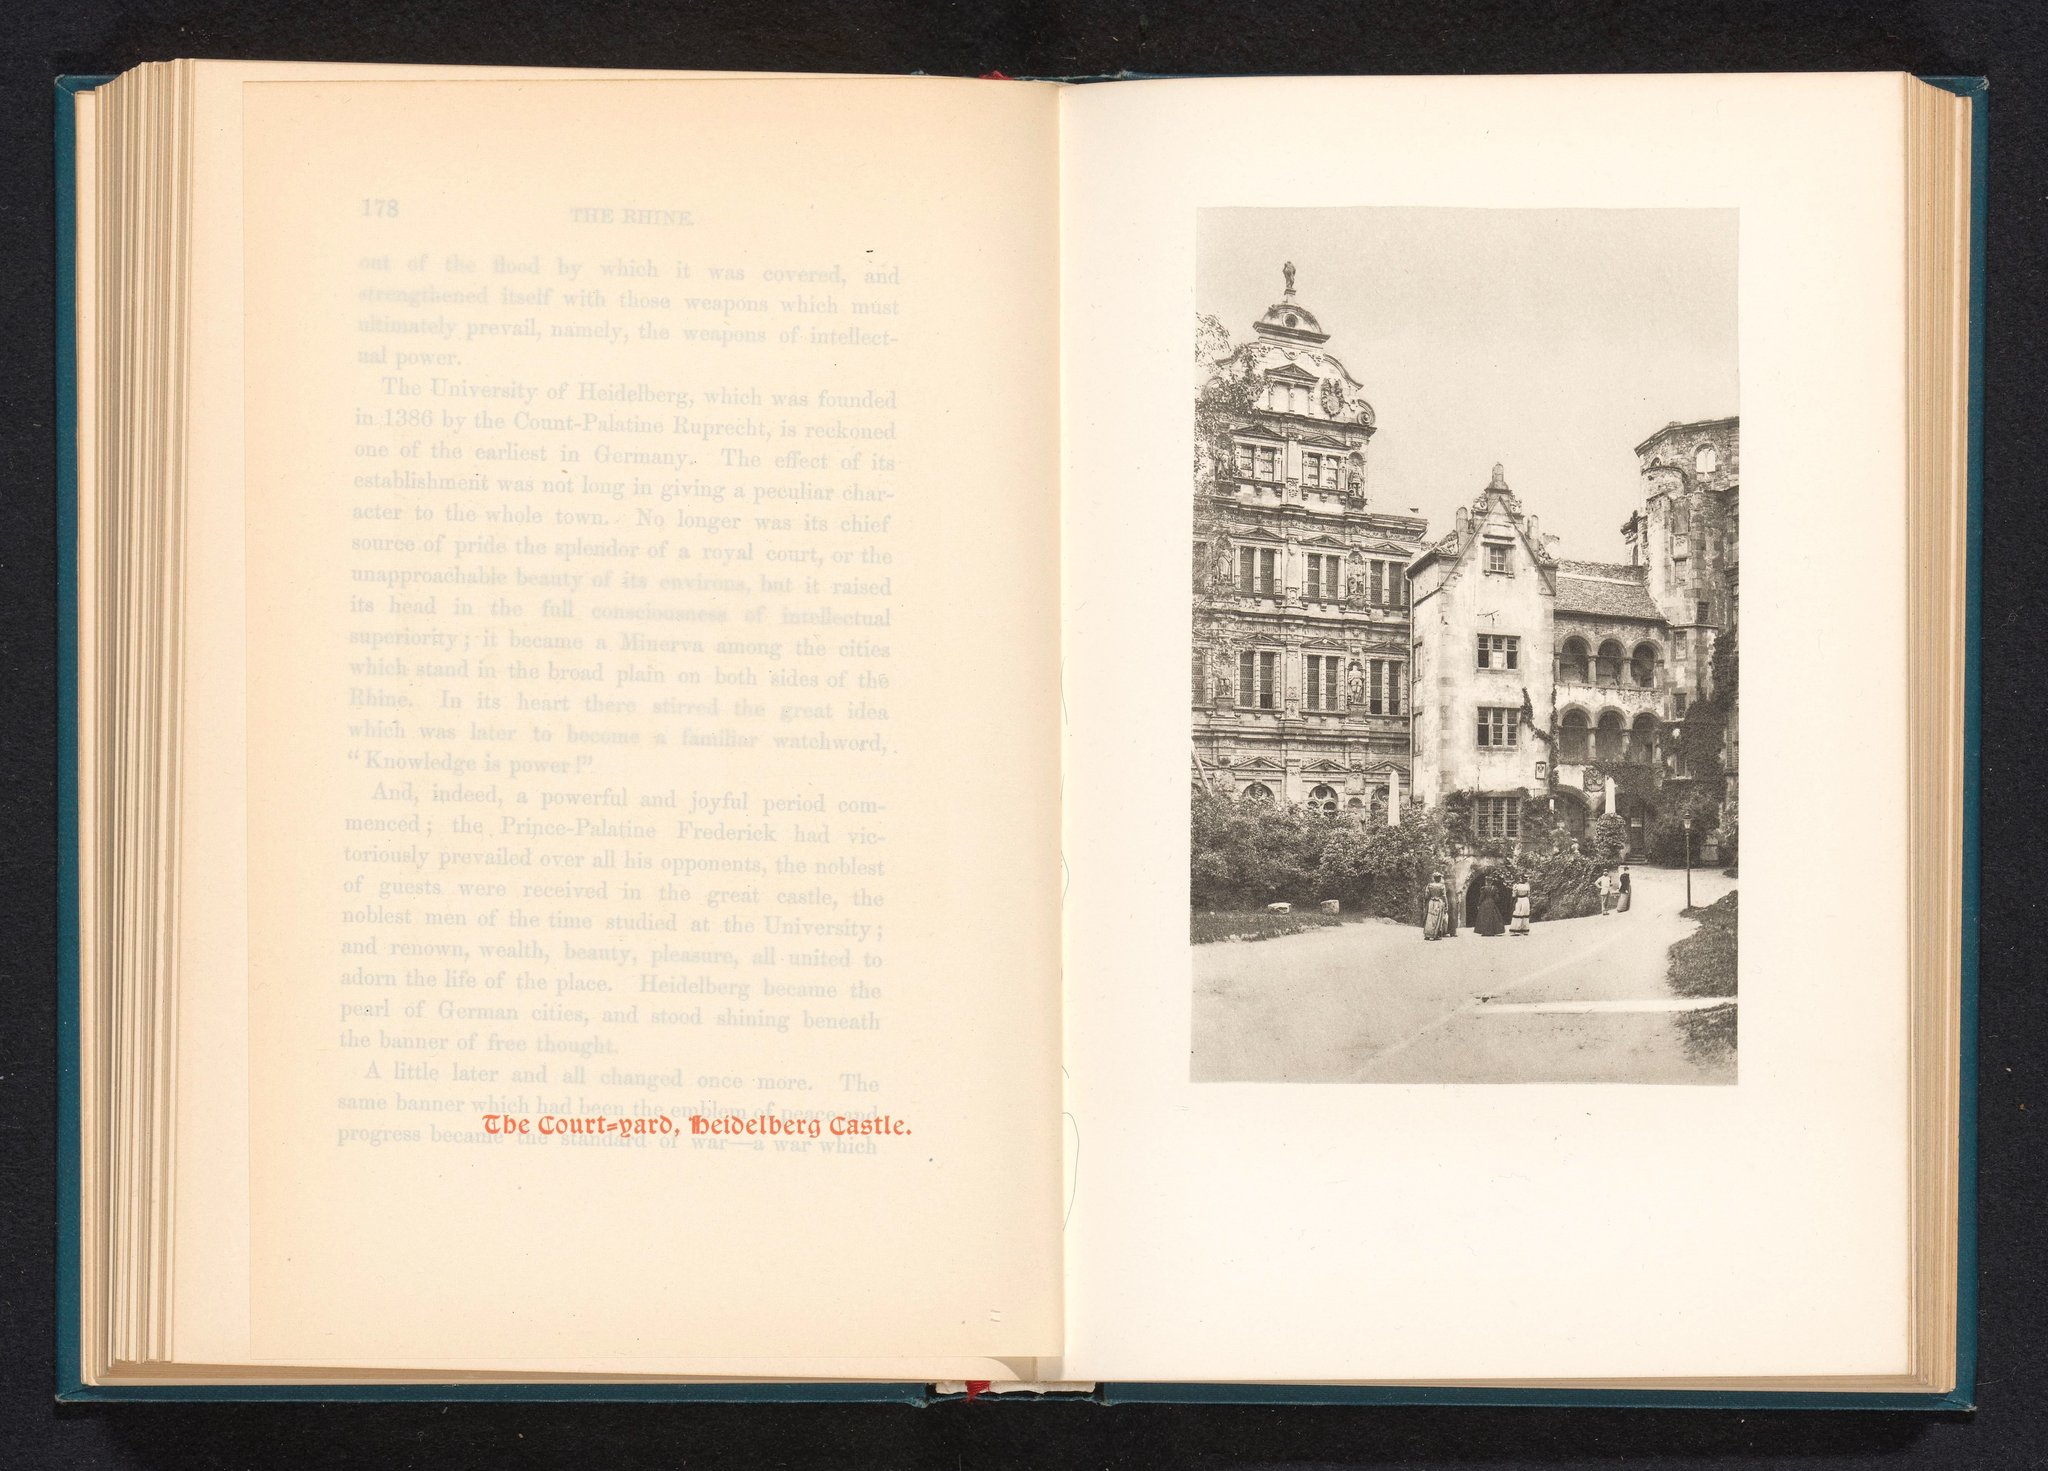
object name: photomechanical print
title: Binnenhof van Schloss Heidelberg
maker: Anonymous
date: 1889-1899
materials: paper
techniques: photoaquatint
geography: heidelberg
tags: castle, façade (of house or building)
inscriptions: title: ‘The Court-yard, Heidelberg Castle.’